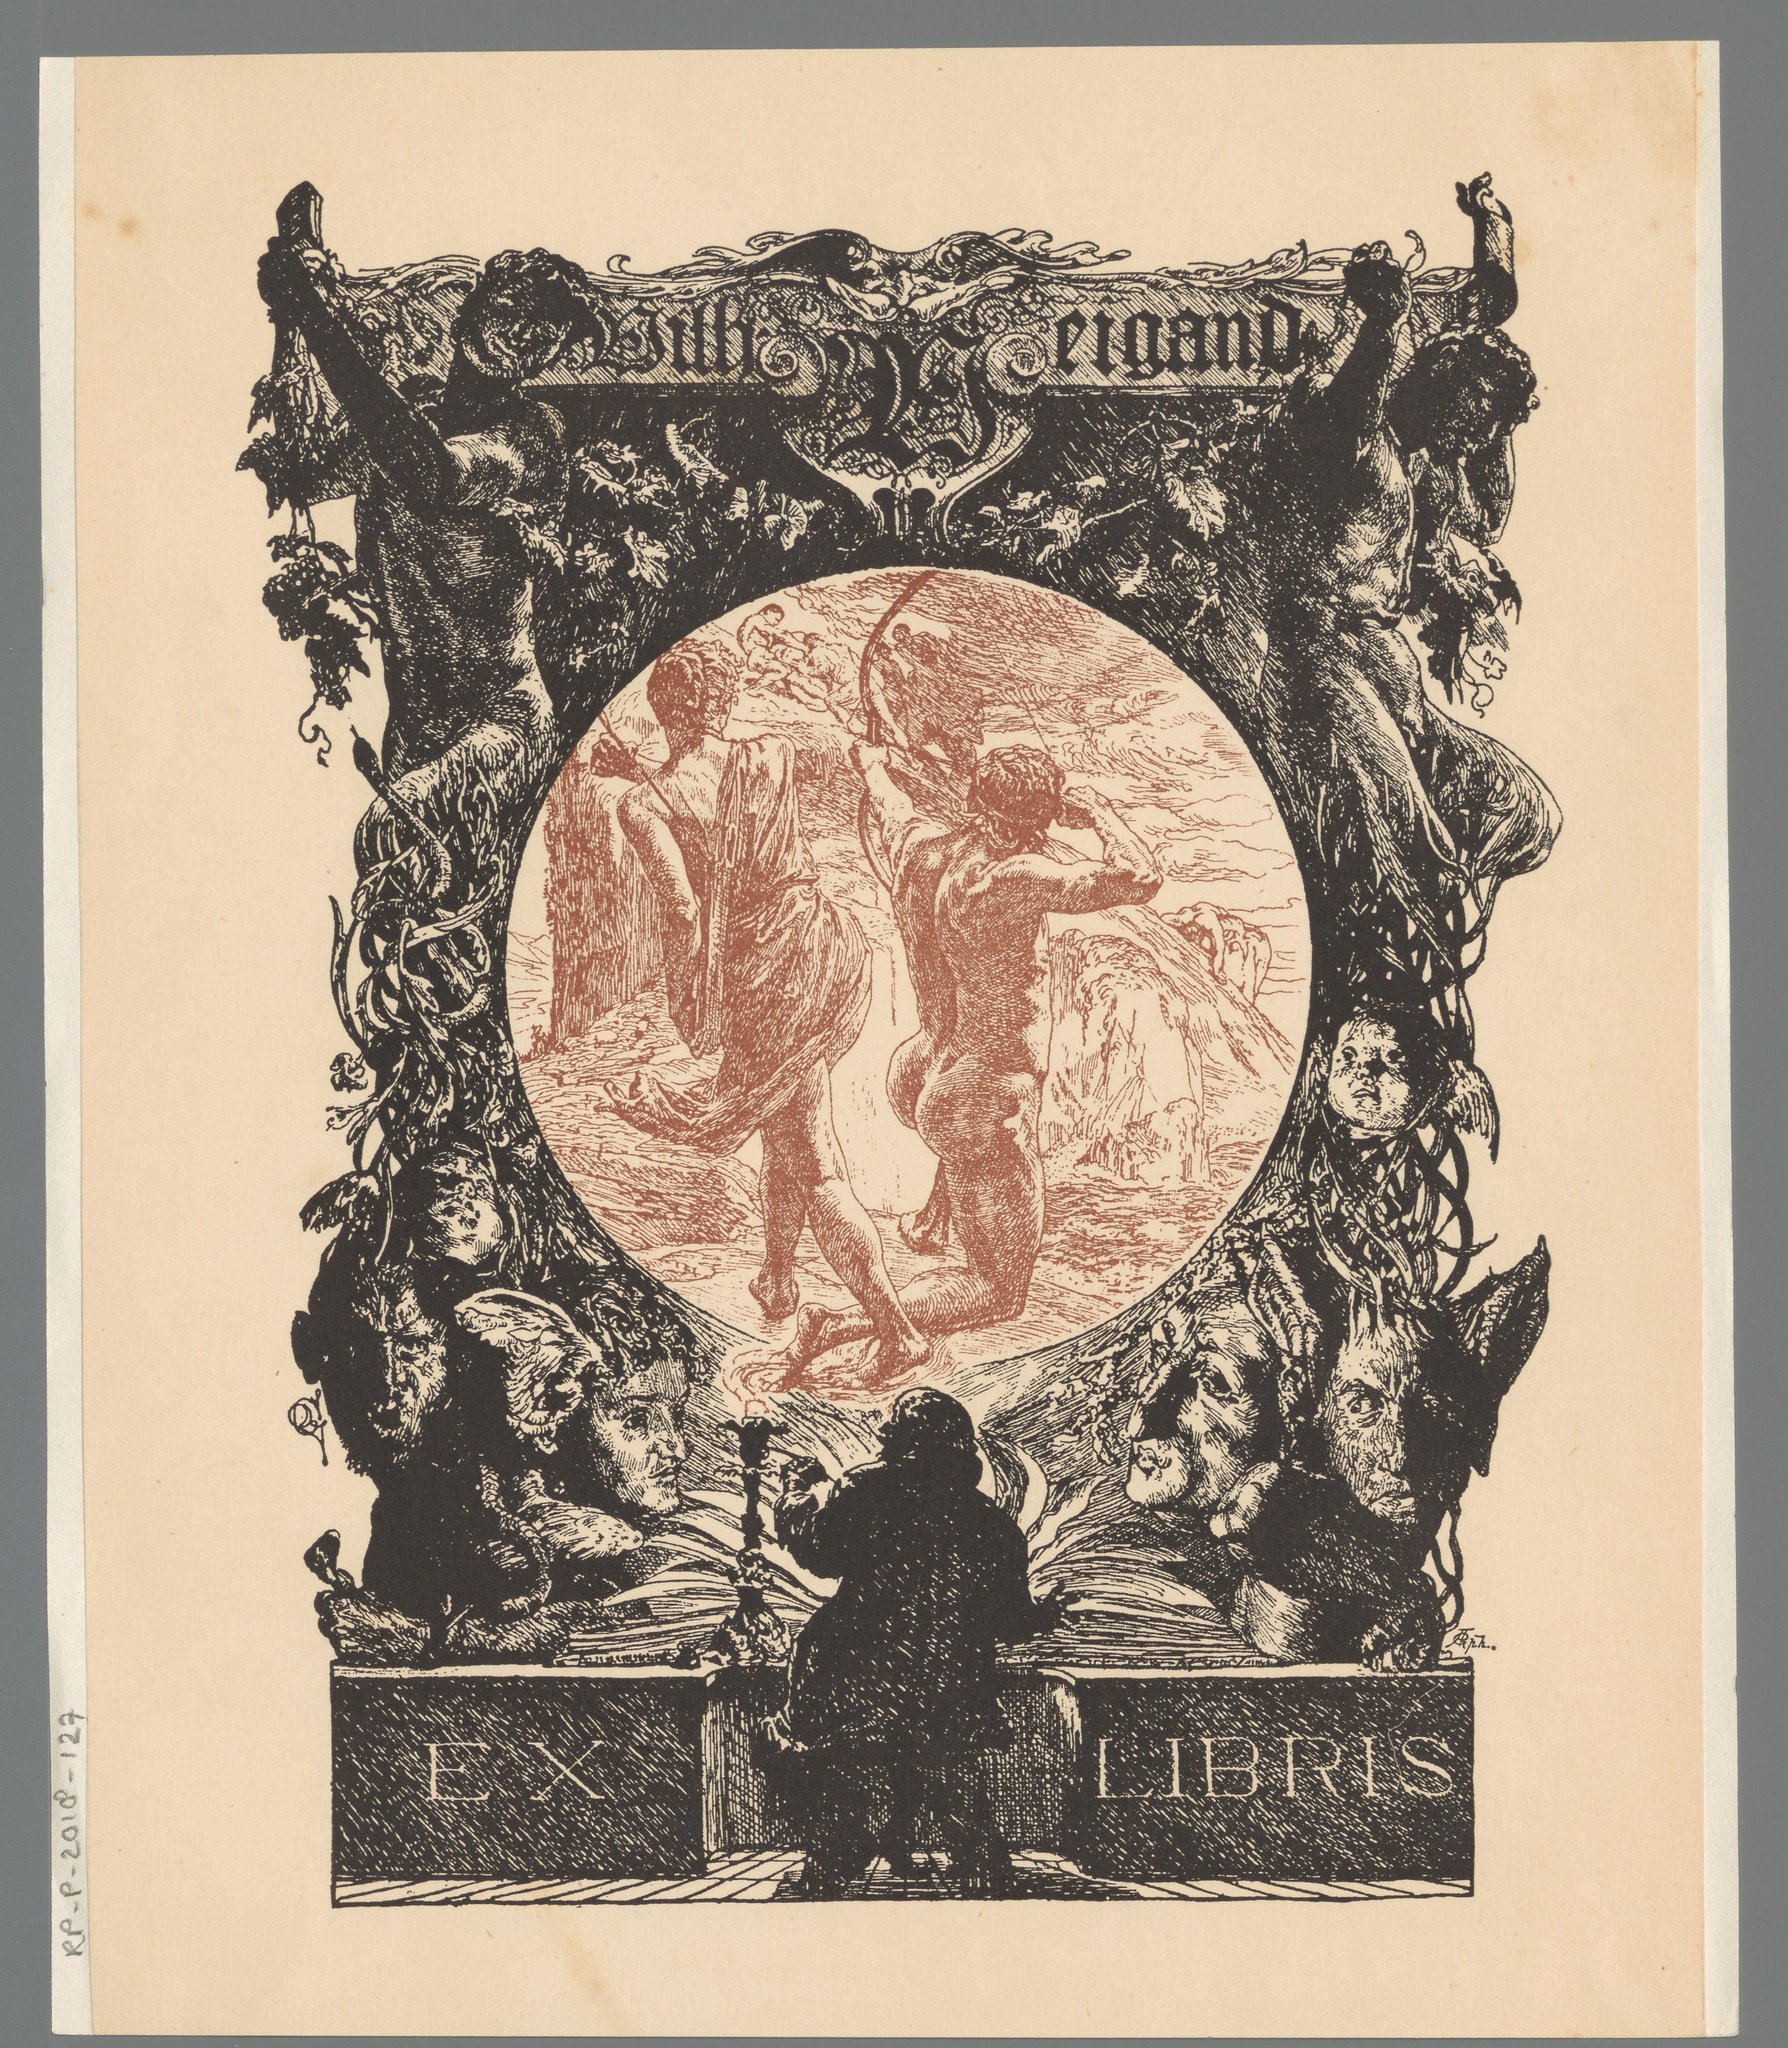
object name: bookplate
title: Ex libris van Wilhelm Weigand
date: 1879-1916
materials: paper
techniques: printing block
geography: germany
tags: sitting figure, devil(s) and demons, book, archer's weapons, man (showing himself) undressed, quasi-nude